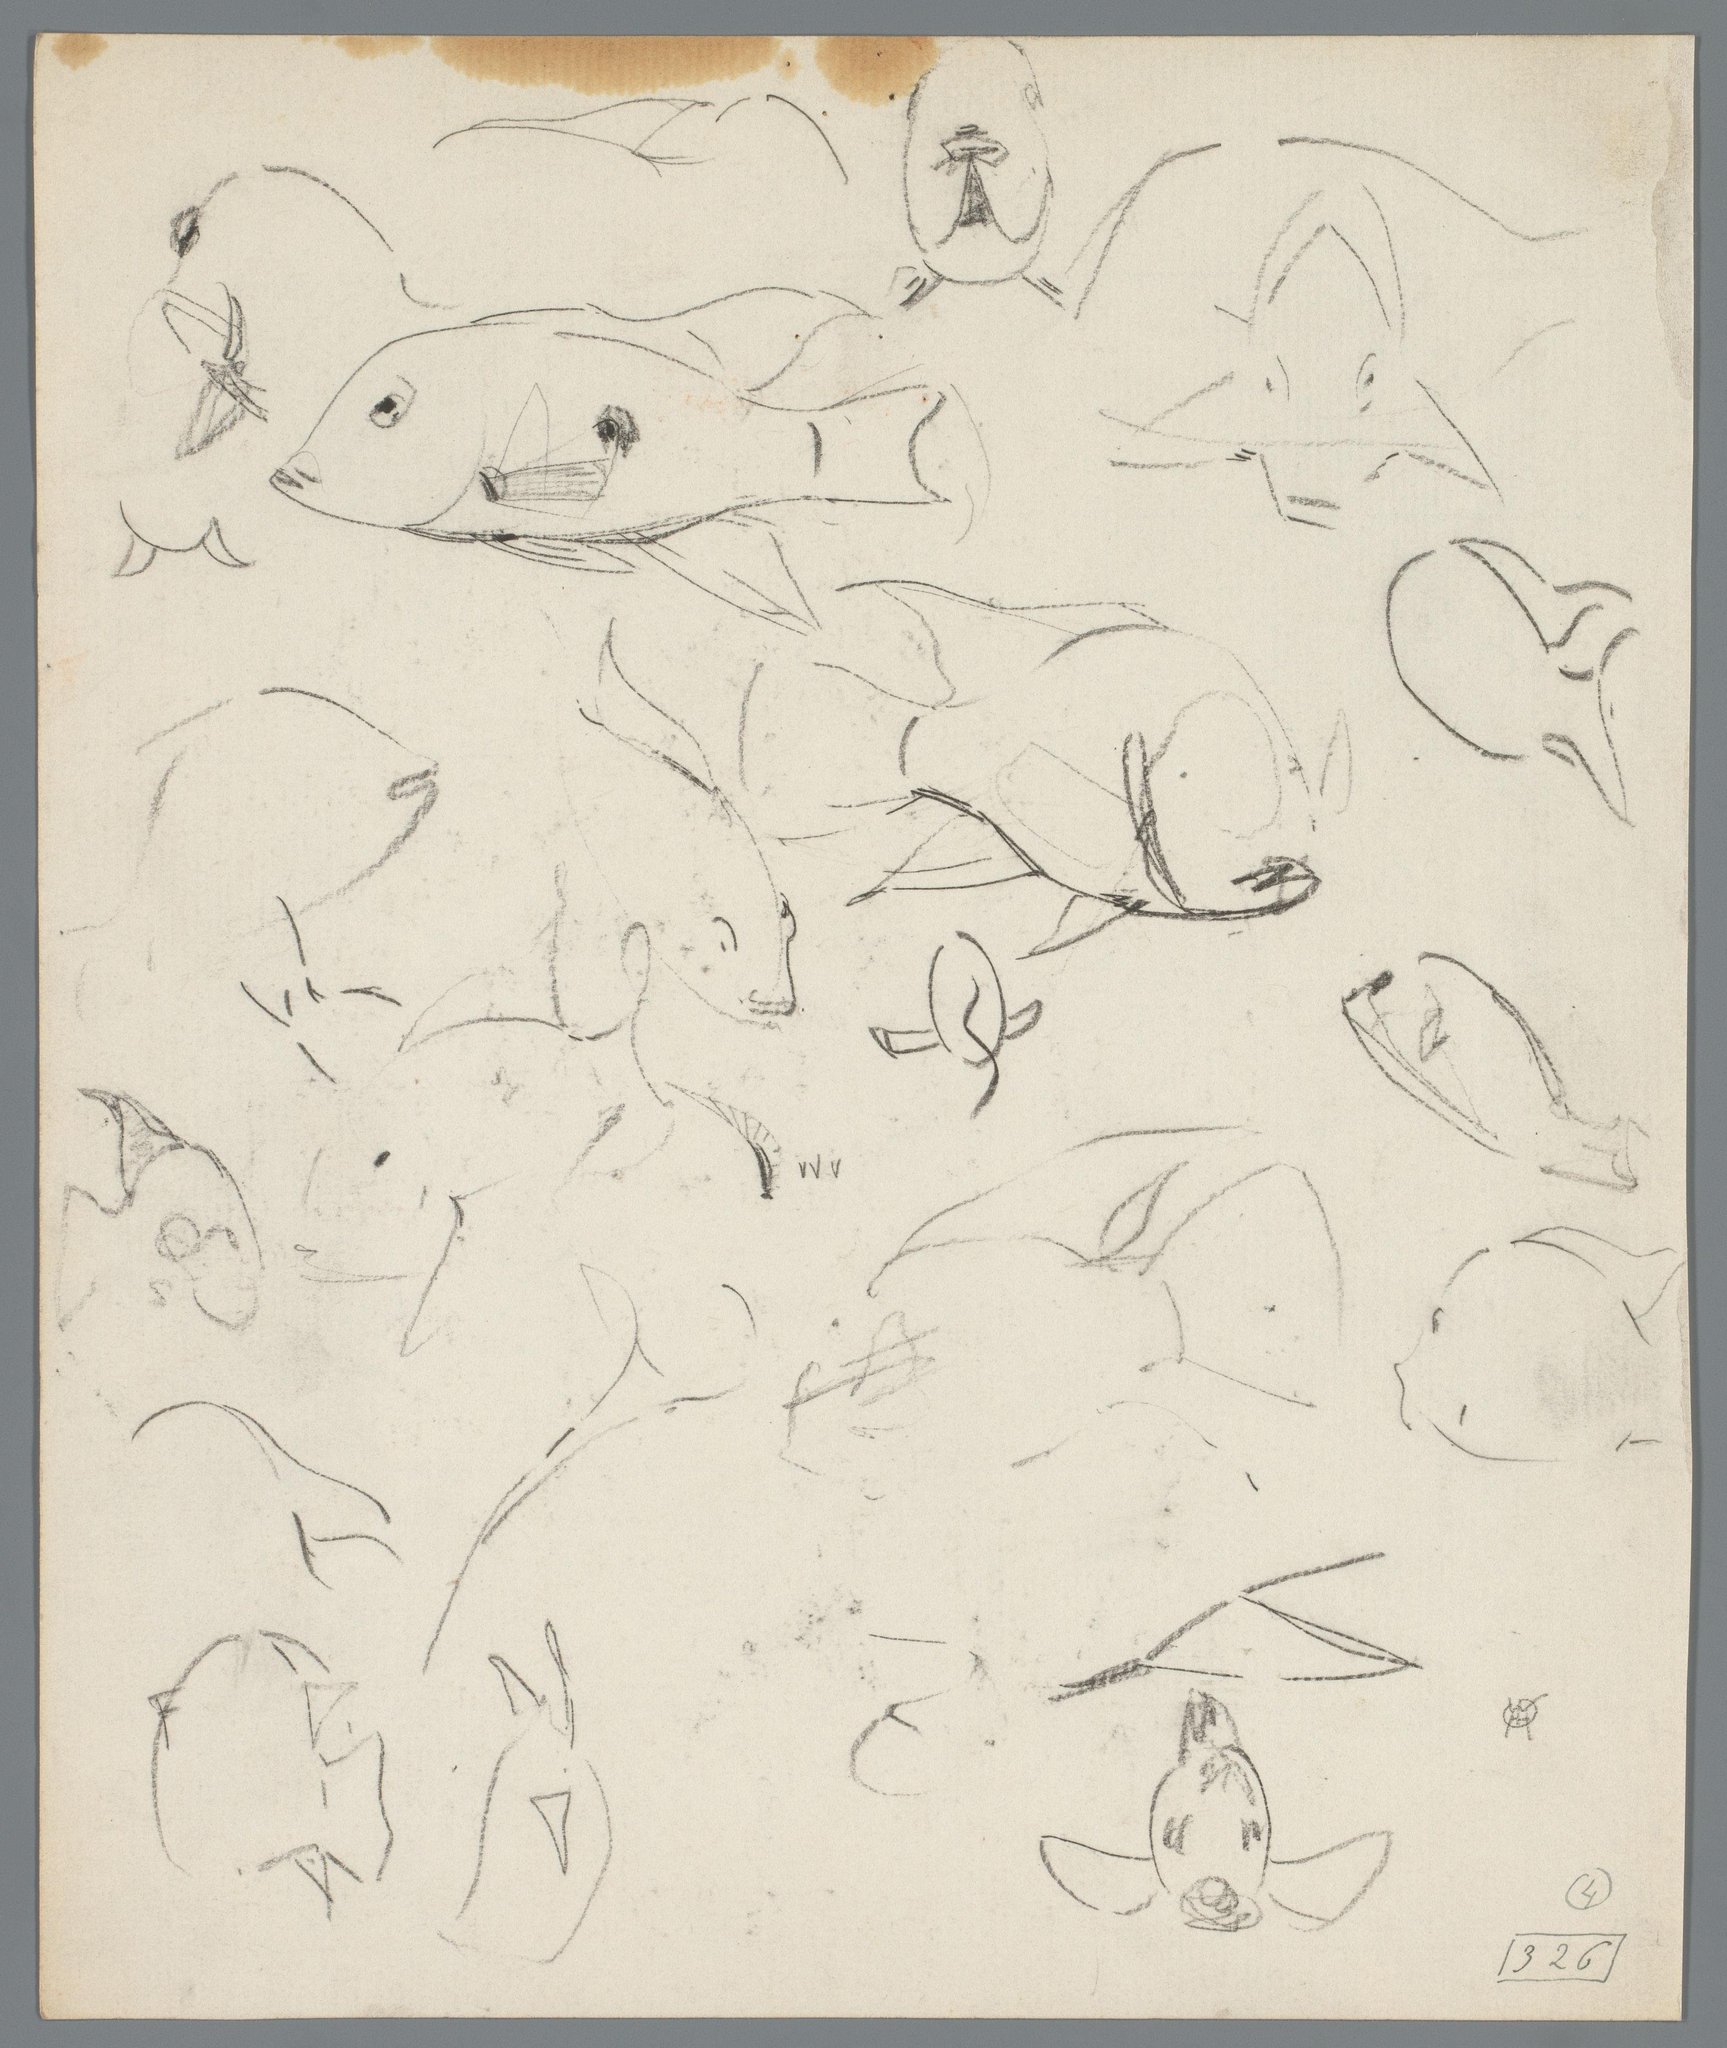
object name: drawing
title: Studieblad met vissen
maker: gerrit willem dijsselhof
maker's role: designer, draughtsman, print maker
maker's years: 1866-1924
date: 1876-1924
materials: chalk, paper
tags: bony fishes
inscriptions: number: ‘326’, number: ‘4’